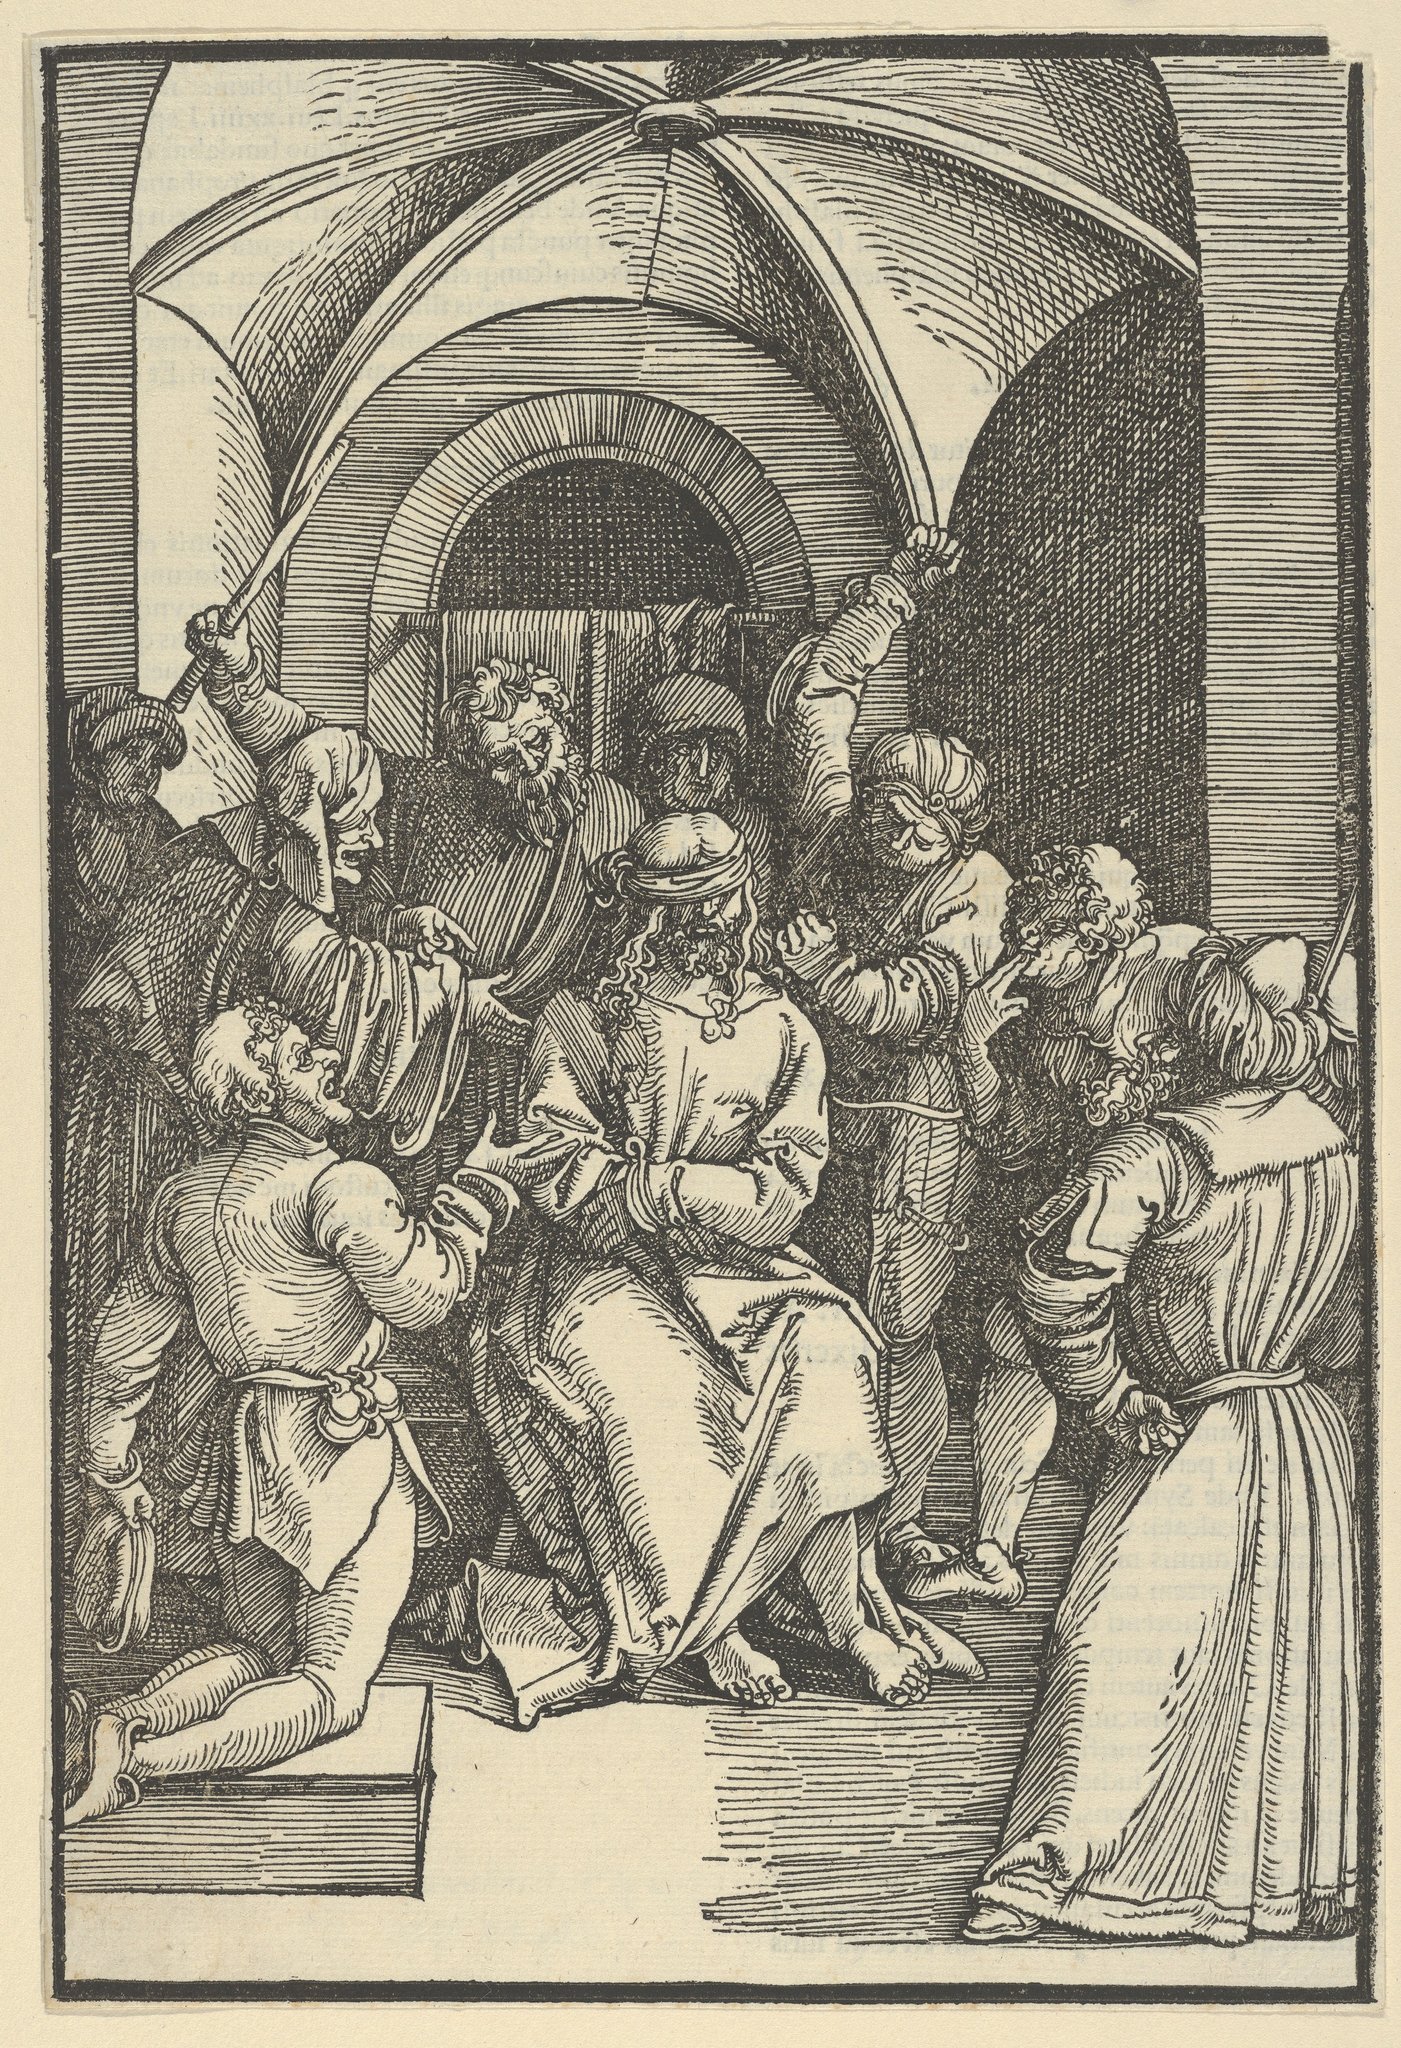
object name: print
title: The Mocking of Christ, from Speculum passionis domini nostri Ihesu Christi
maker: hans schäufelein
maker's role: artist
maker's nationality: german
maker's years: 1480-1540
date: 1507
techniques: woodcut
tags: suffering,men,christ